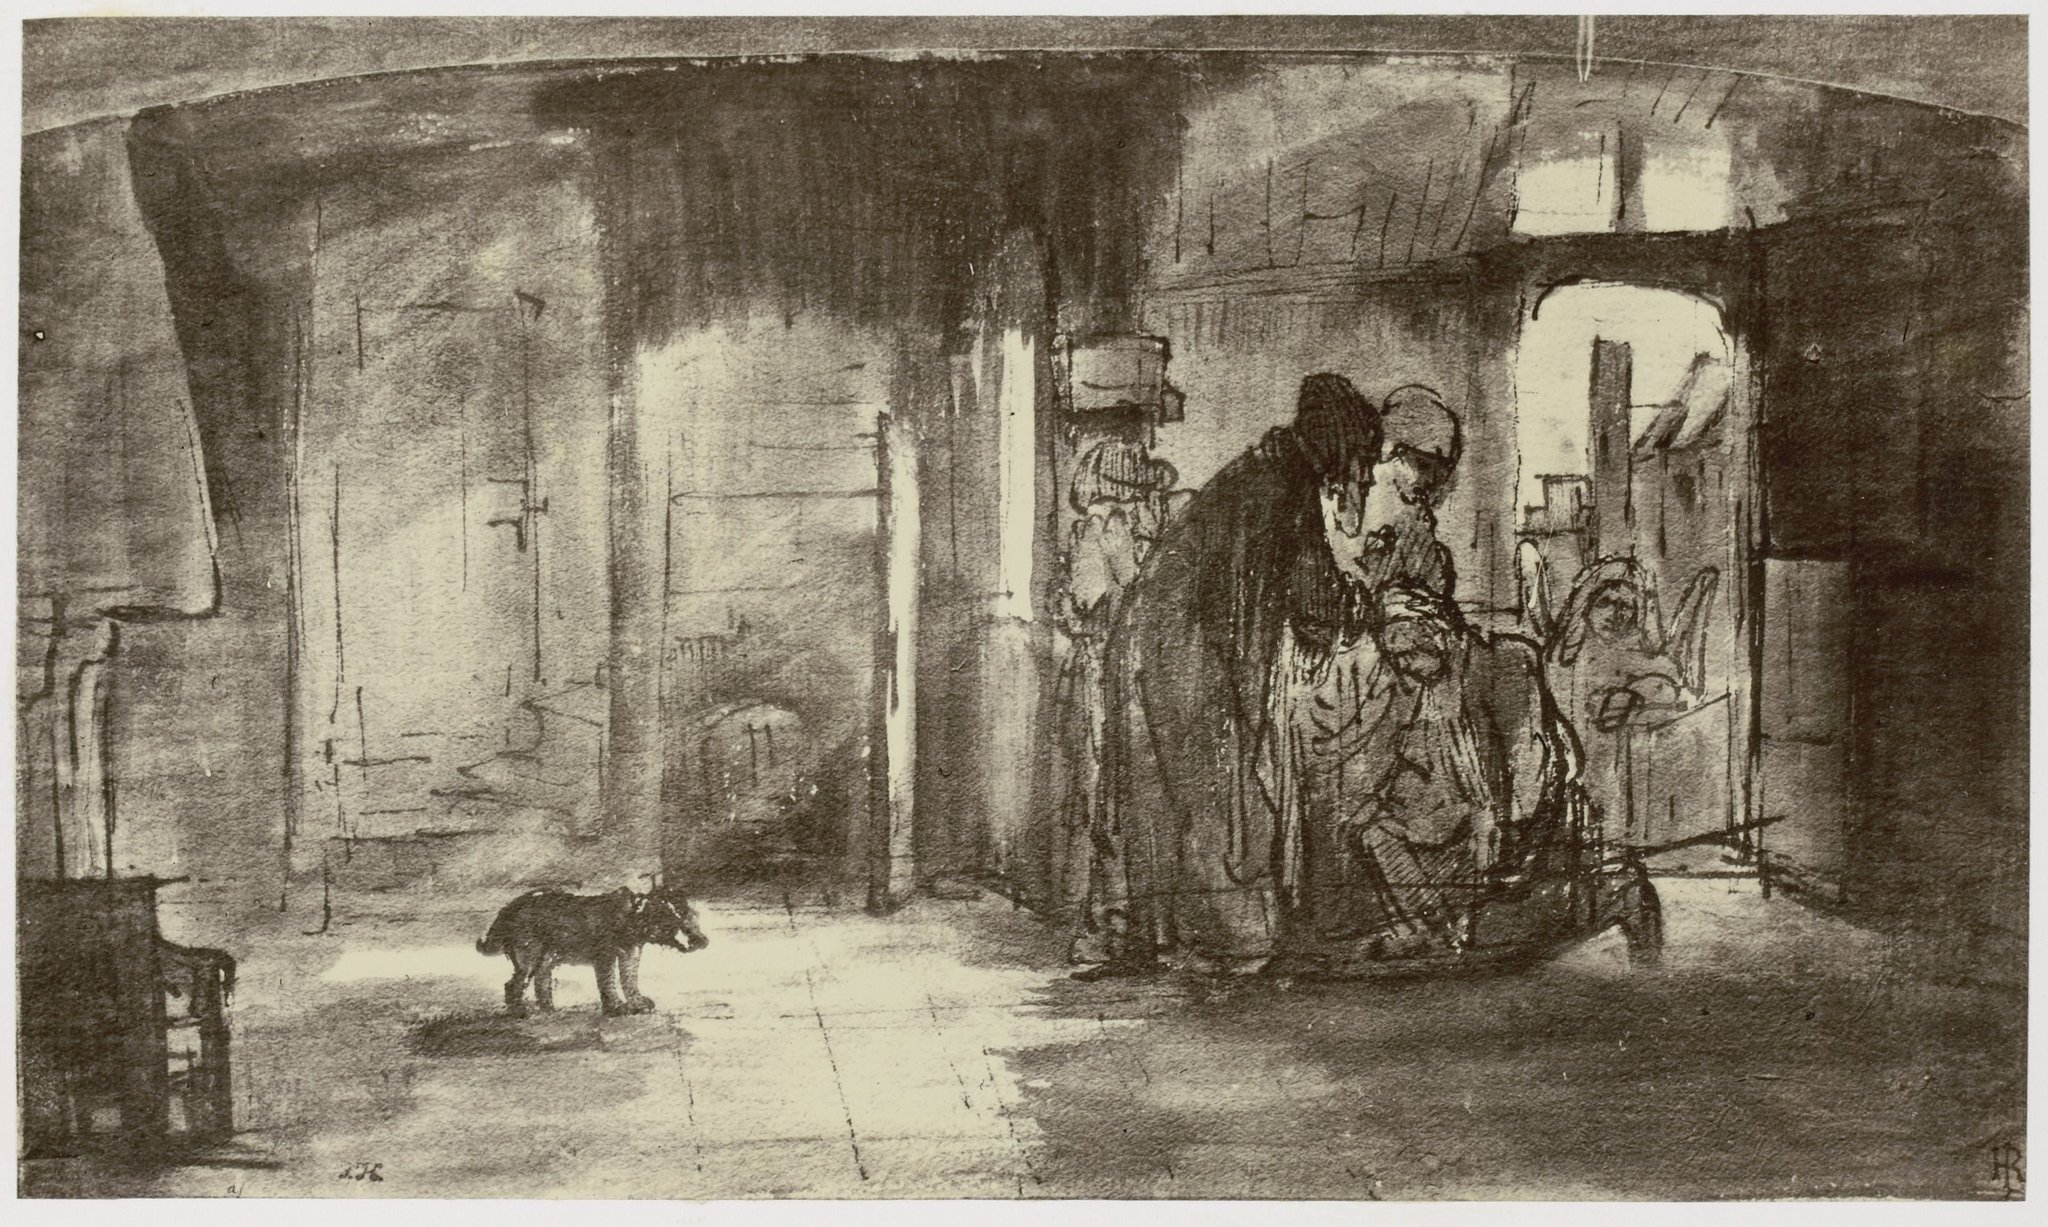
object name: photograph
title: Rembrandt, Tobiat blessing Tobias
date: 1855-1858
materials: cardboard, paper, photographic support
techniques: albumen print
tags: drawing, sketch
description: Fotoreproductie van tekening in 'The Reveley Collection of Drawings at Brynygwin', afb. 10.